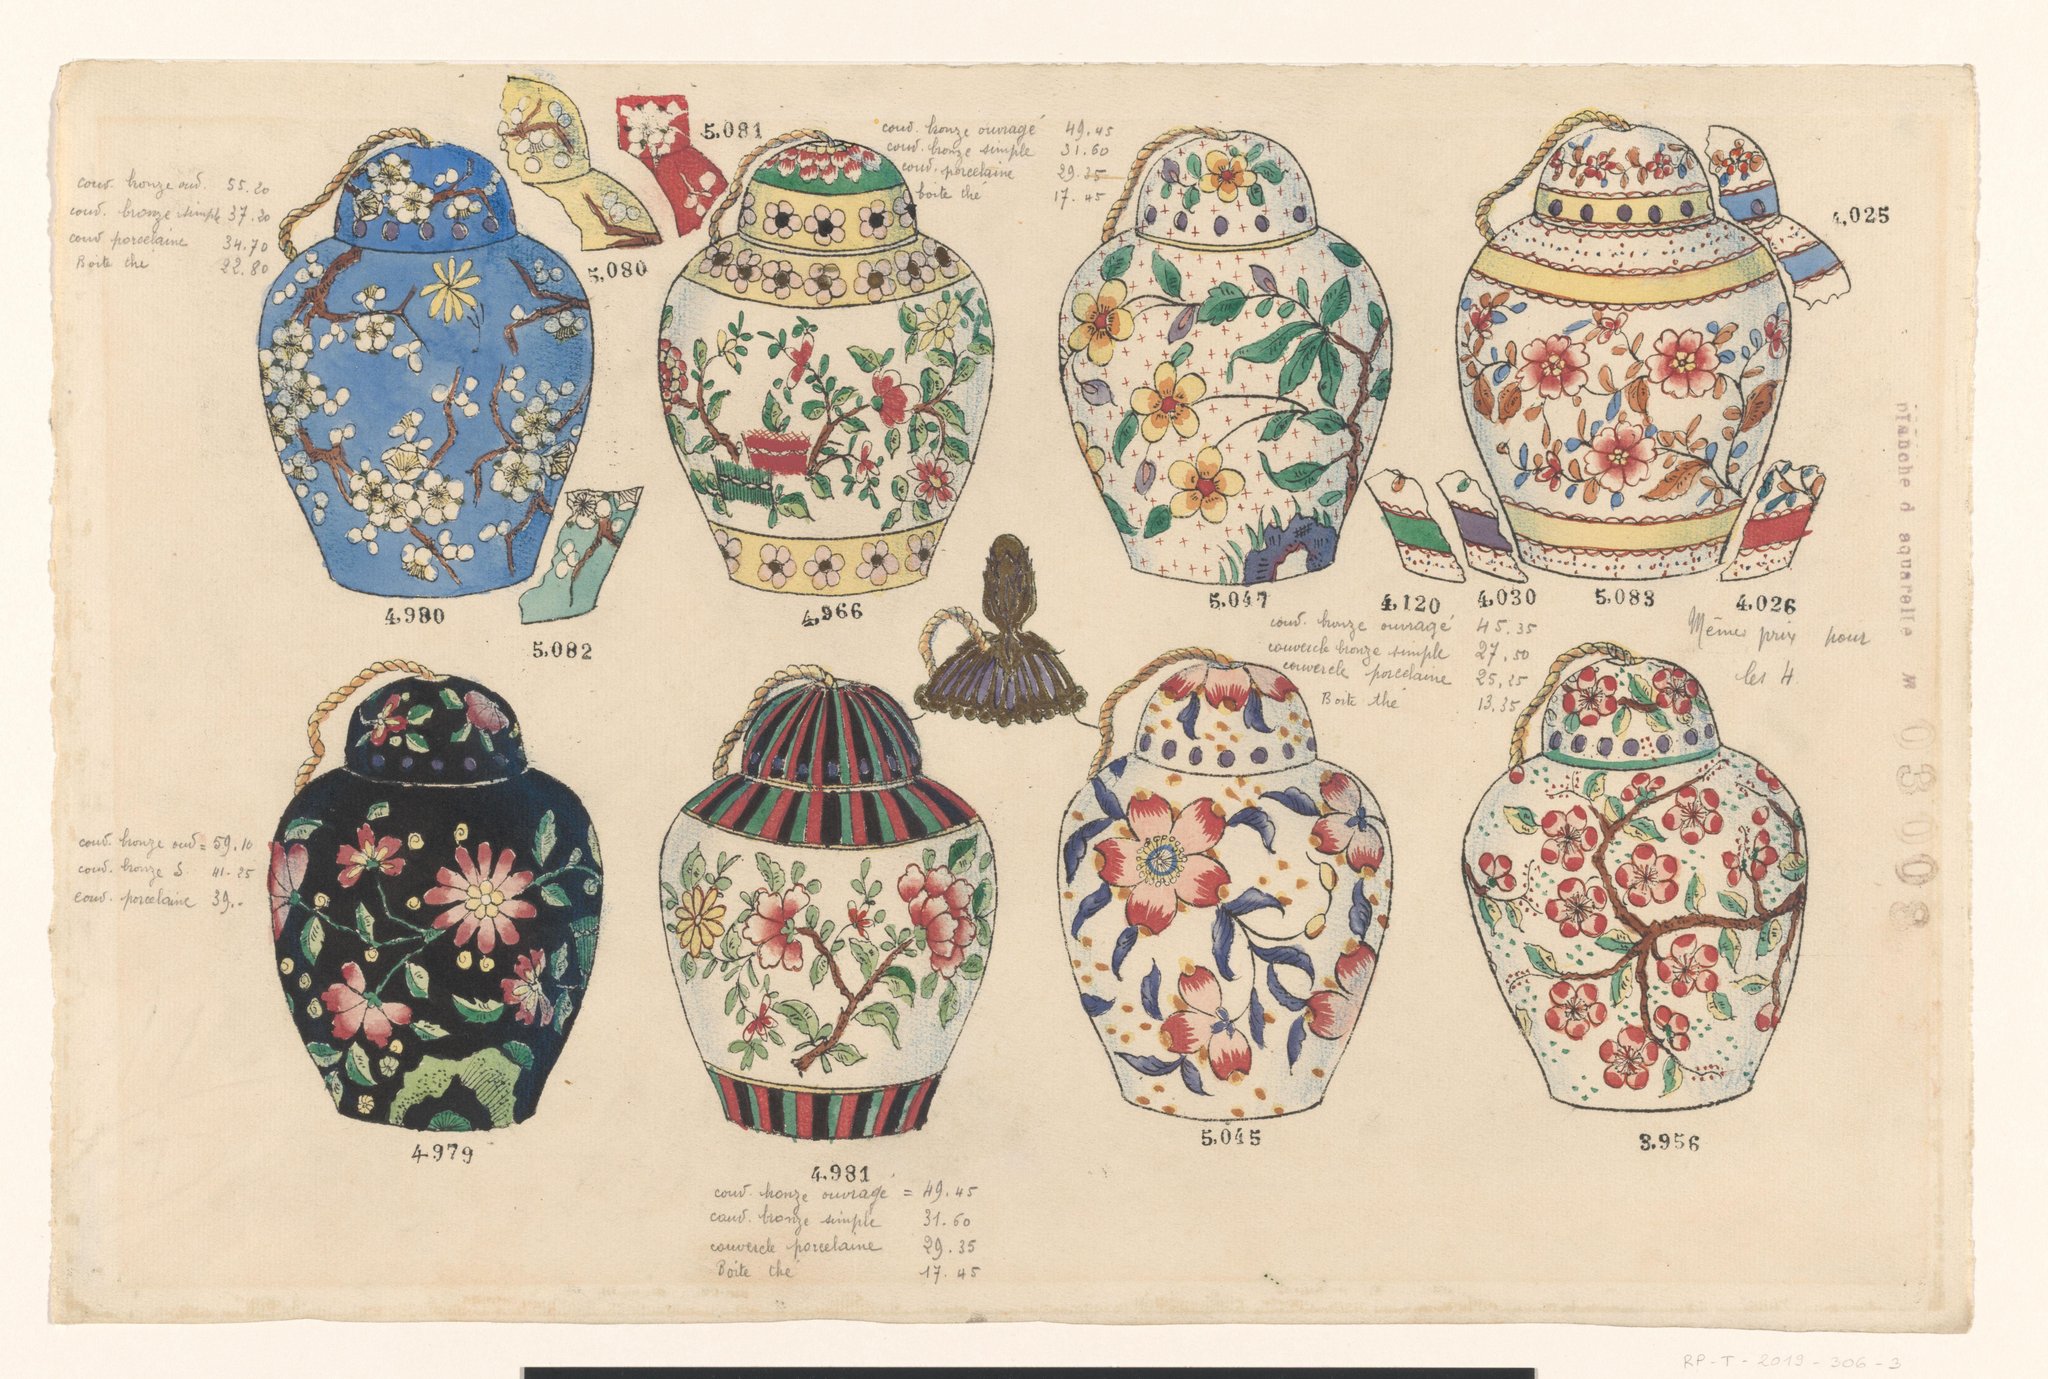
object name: drawing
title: Zes bladen uit een produktiecatalogus van een ceramiekmanufactuur of -handelaar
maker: Anonymous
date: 1900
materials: ink, paper, watercolor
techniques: brush, pen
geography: france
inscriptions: stamp: ‘planche d'aquarelle No 03008’, inscription, stamp, watermark: ‘MBM’